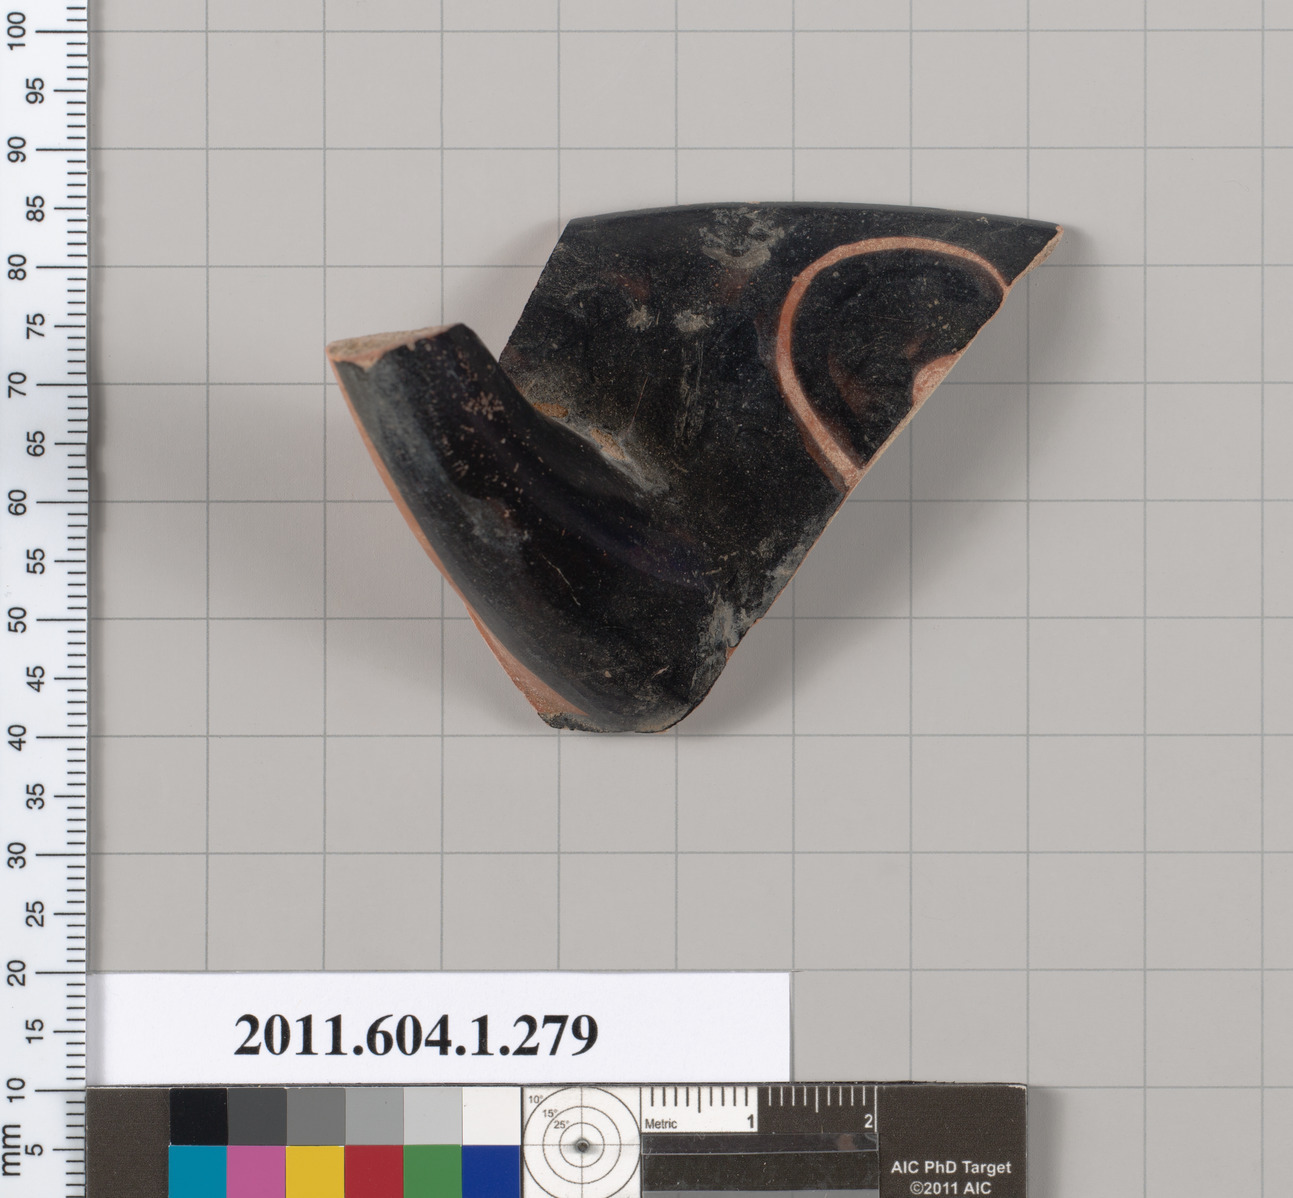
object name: kylix fragment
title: Terracotta rim fragment of a kylix (drinking cup)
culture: greek, attic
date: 475-451 BCE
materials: terracotta